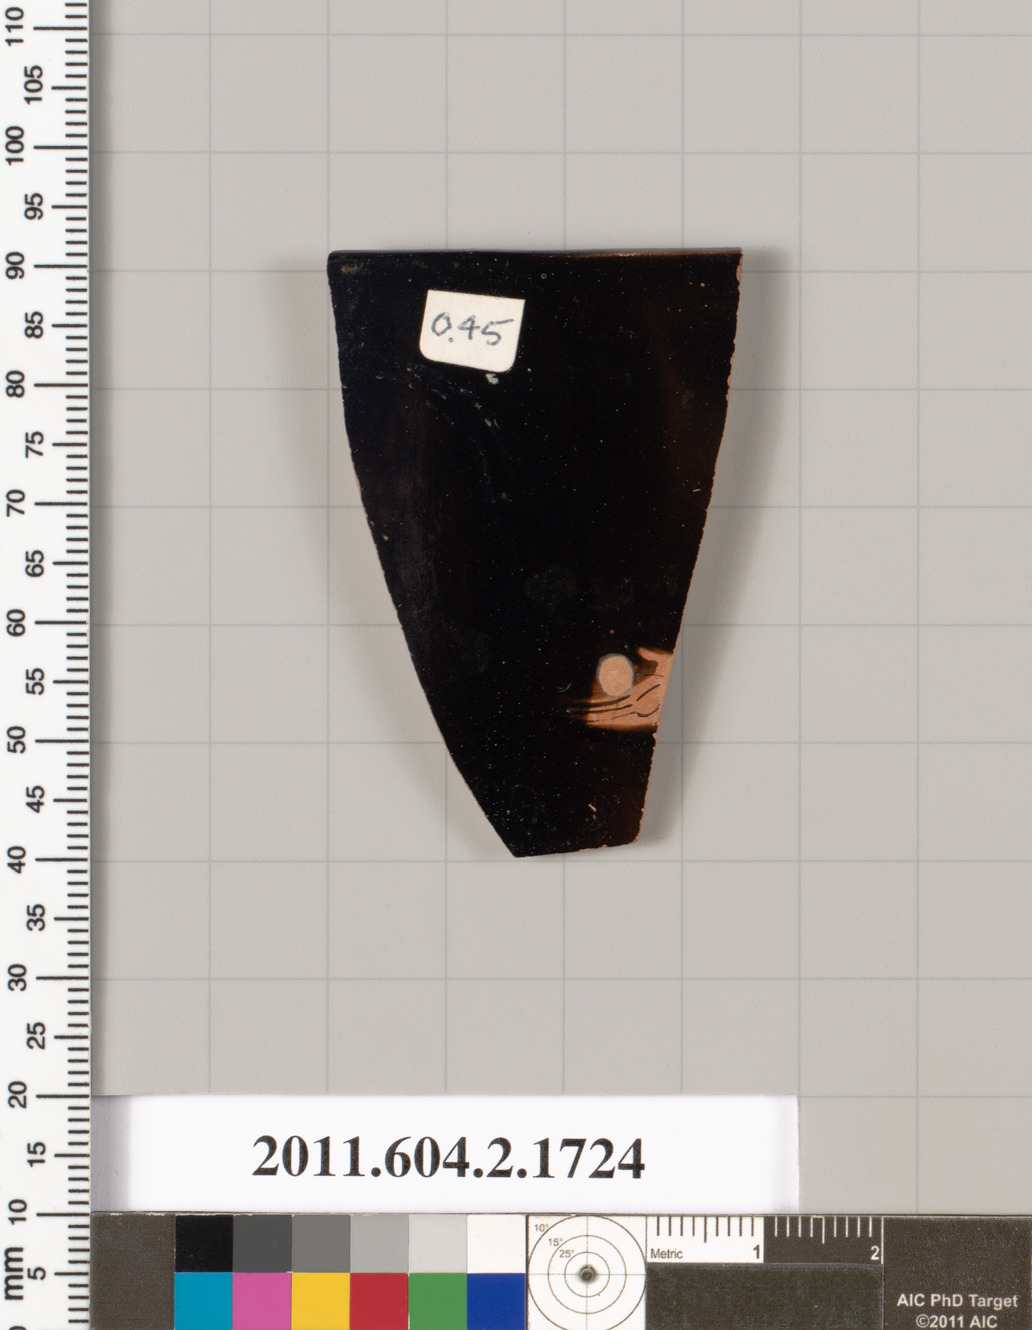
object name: skyphos fragment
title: Terracotta rim fragment of a skyphos (deep drinking cup)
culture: greek, attic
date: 475-451 BCE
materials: terracotta